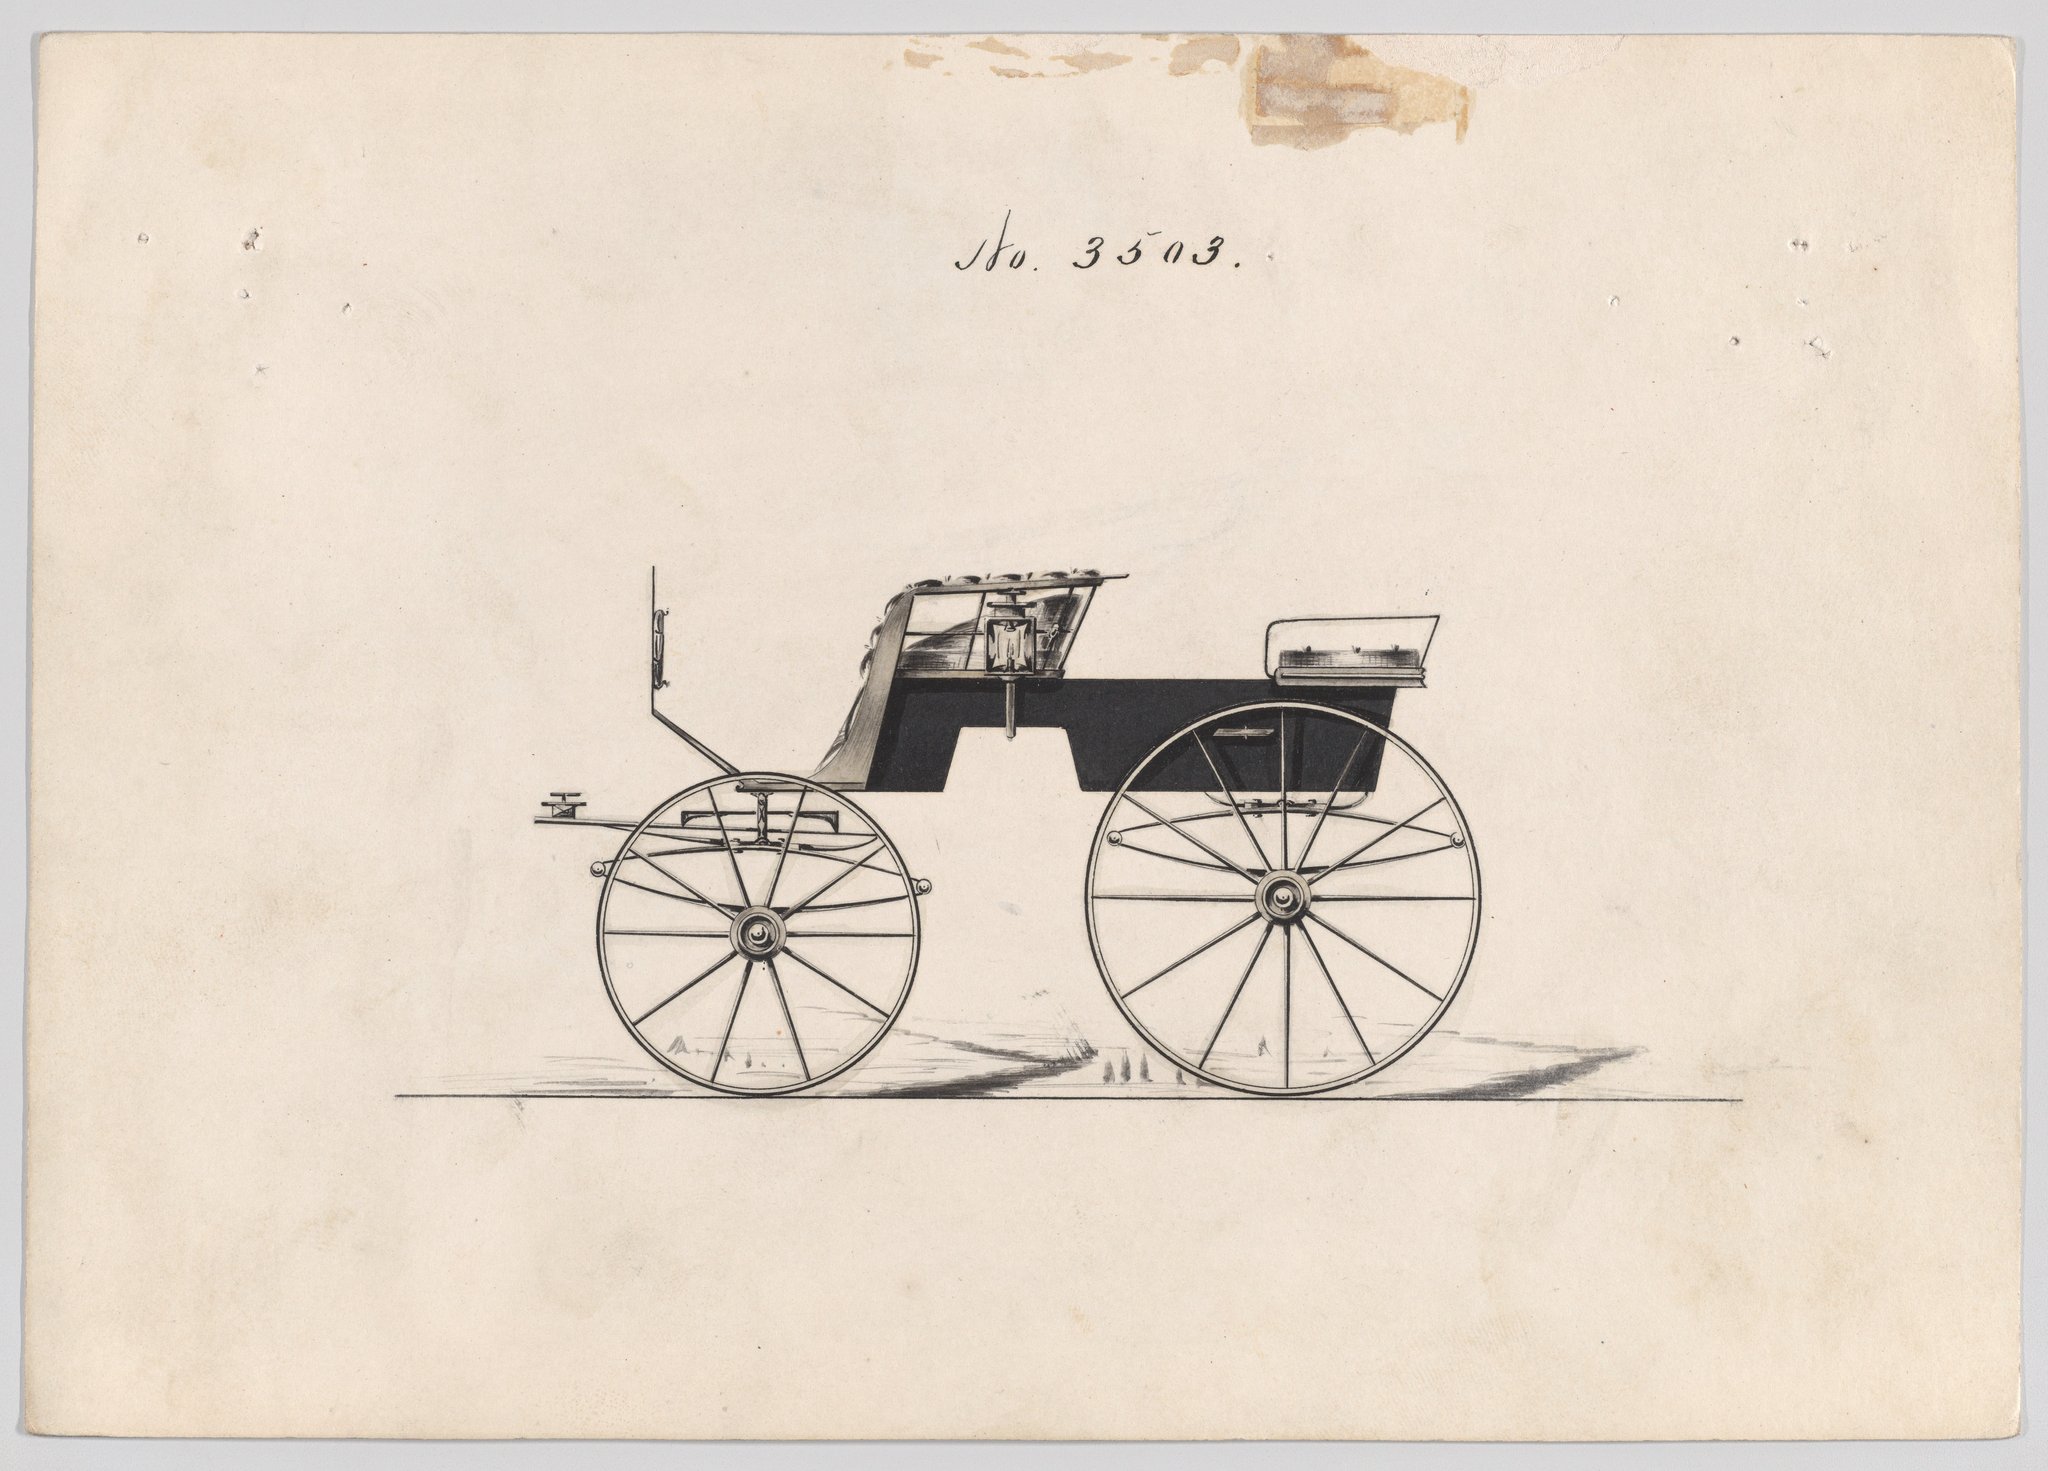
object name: drawing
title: Design for T-Cart, no. 3503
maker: brewster & co.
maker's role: manufacturer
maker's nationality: american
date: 1879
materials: gouache, gum arabic, ink, watercolor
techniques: pen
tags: carriages